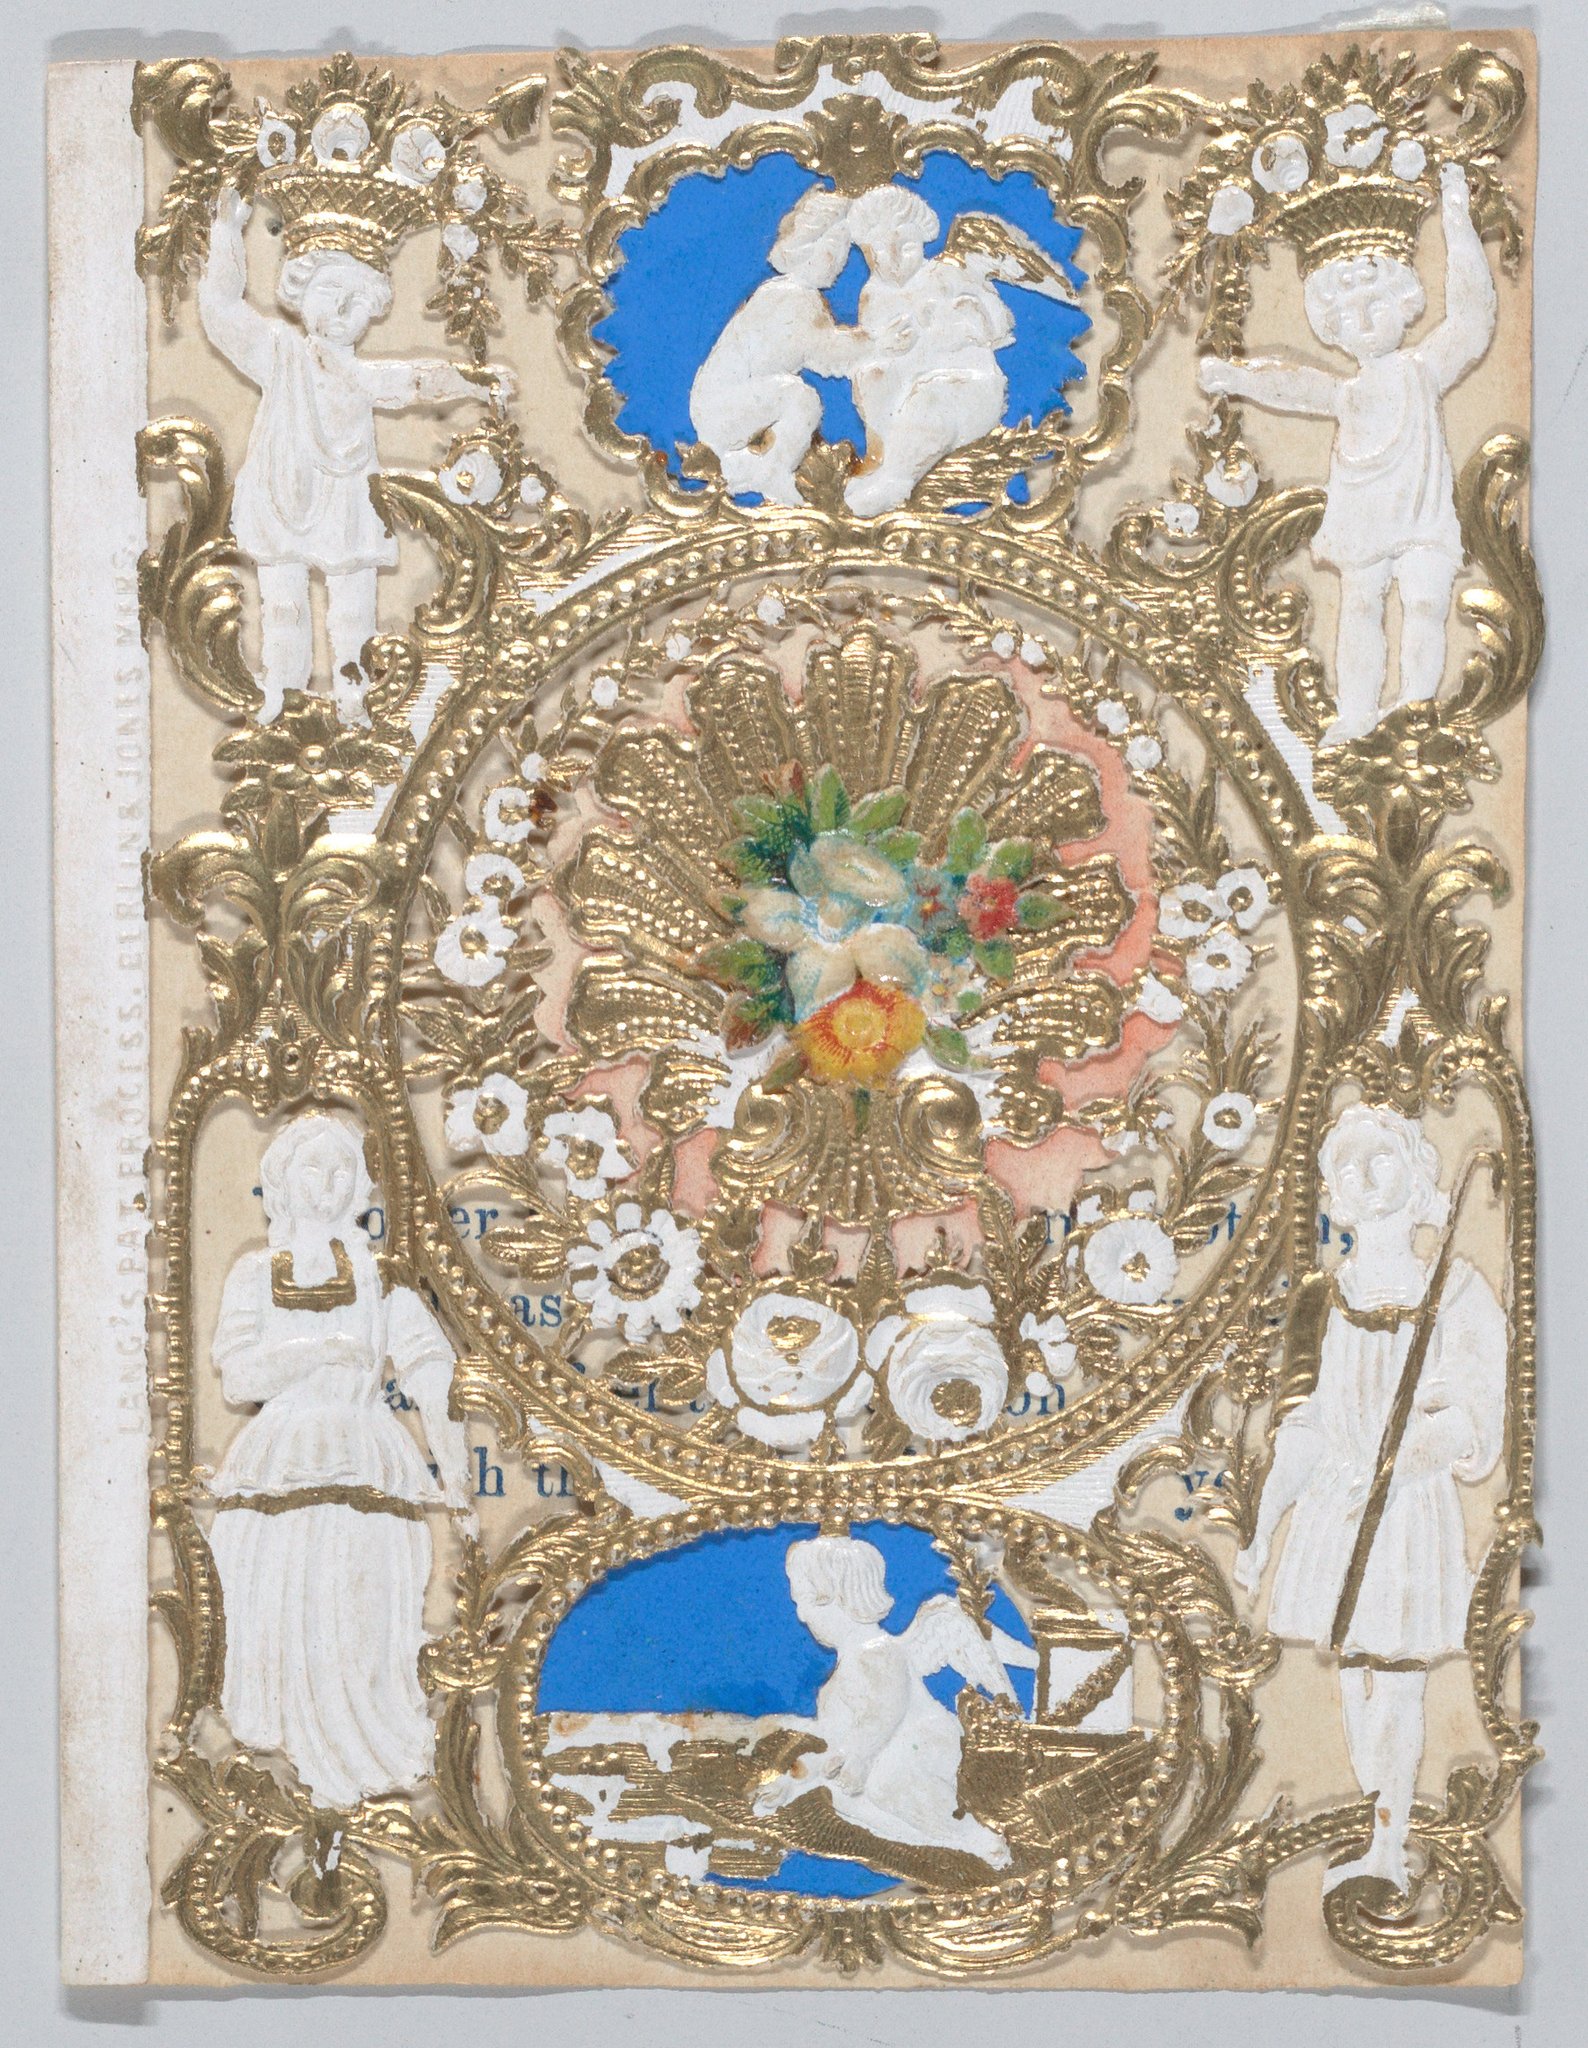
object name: valentine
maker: Anonymous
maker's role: artist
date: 1850-1860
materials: lace, paper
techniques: cutting, embossing, gilding, open work